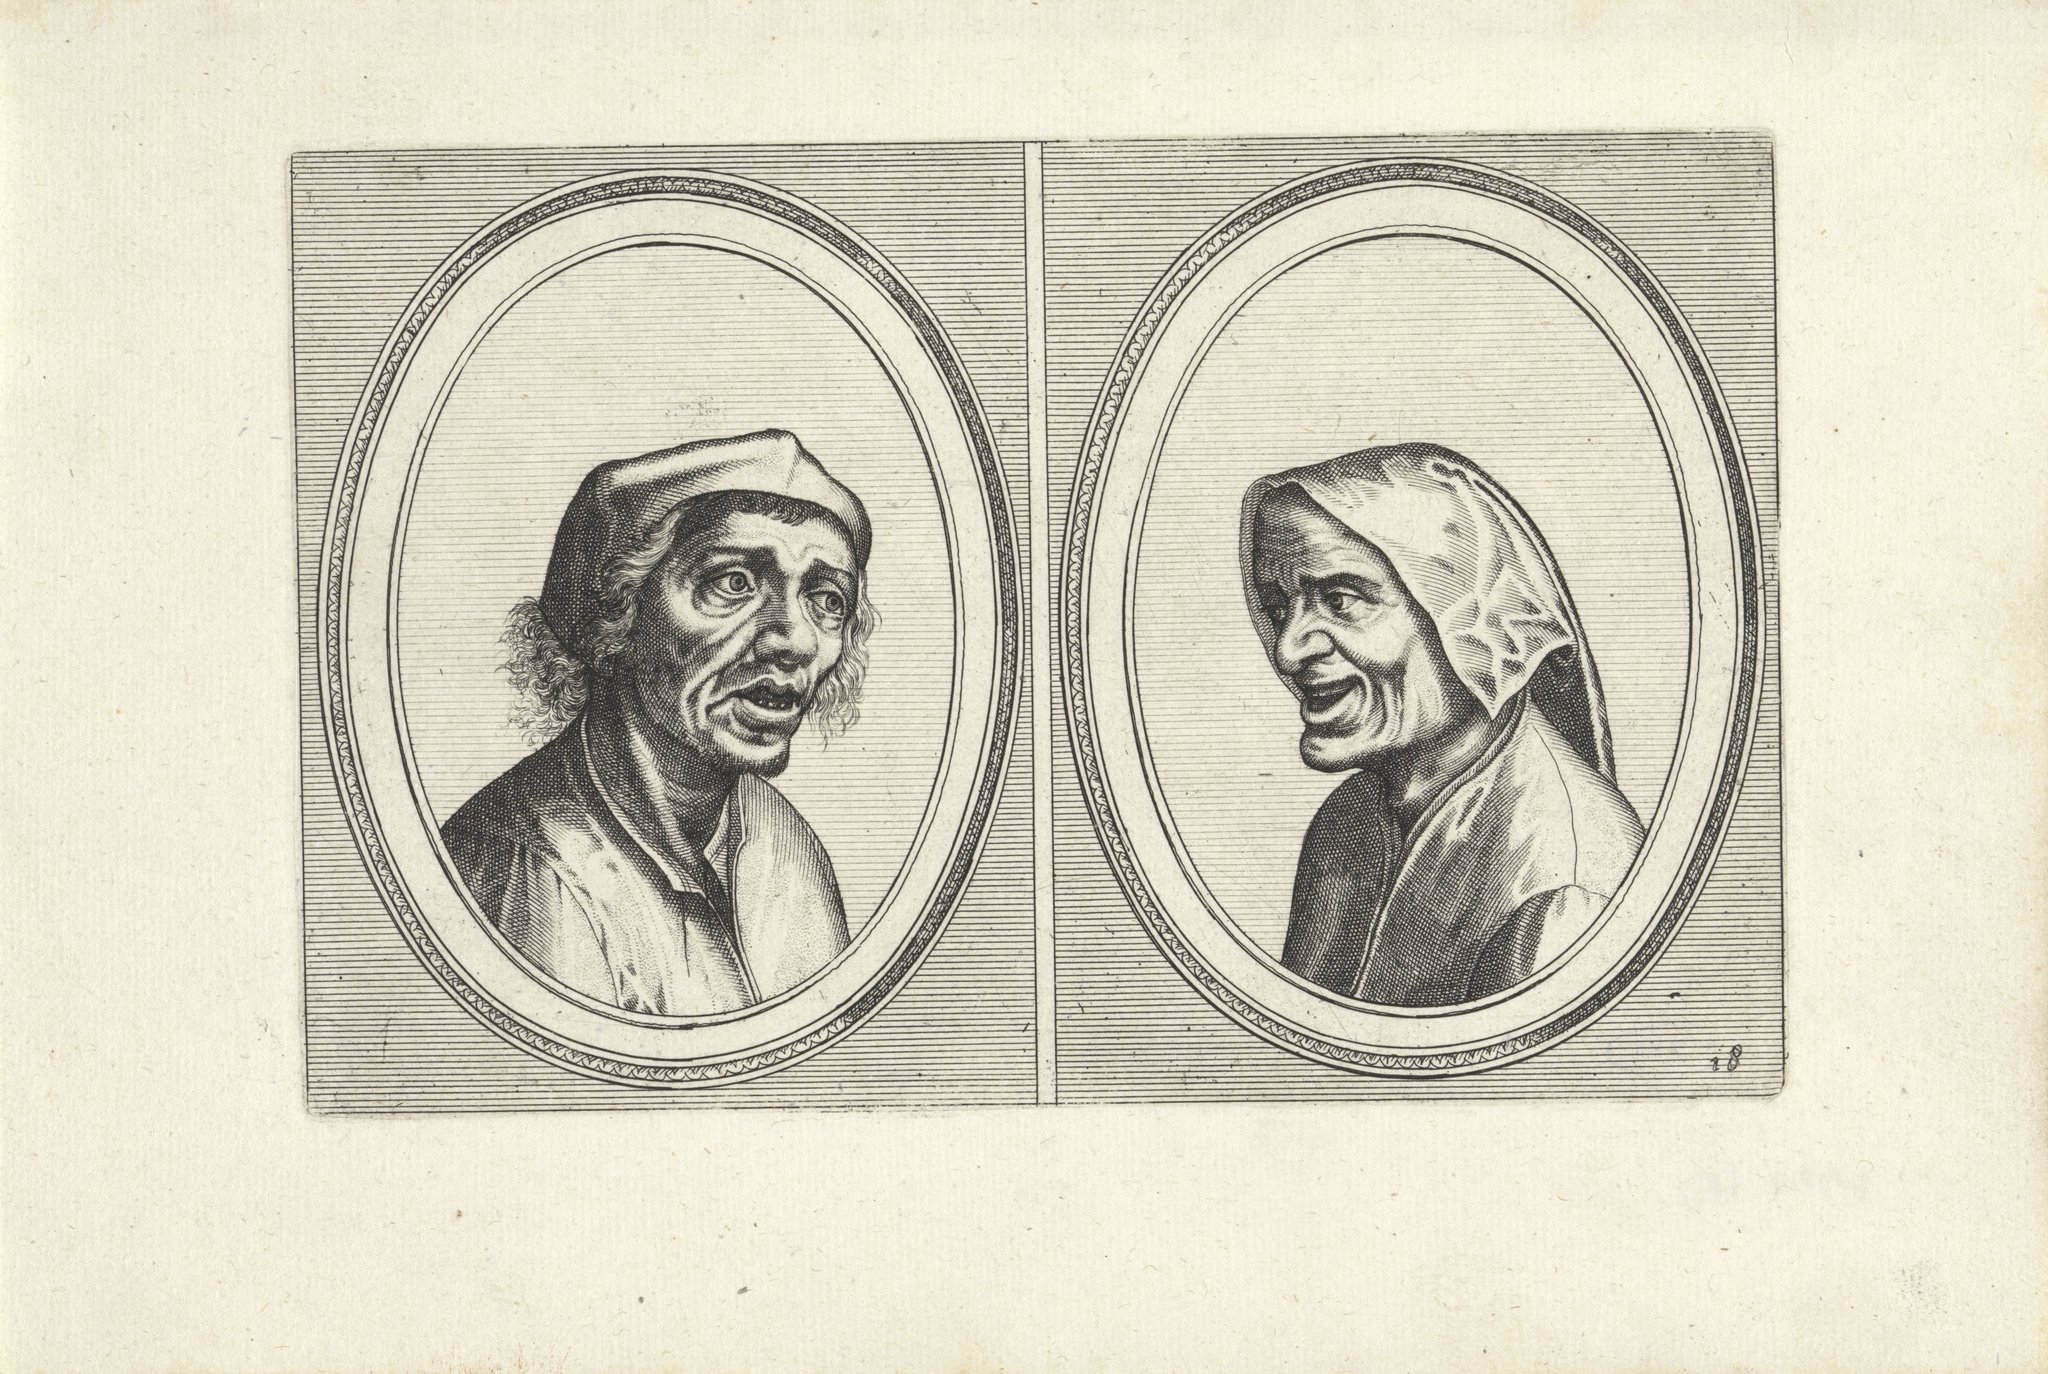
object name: print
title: Goê Geurtjen en Kribbighe Babbe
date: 1612-1652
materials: paper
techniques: engraving, etching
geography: amsterdam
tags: head-gear, farmers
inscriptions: collector's mark: Lugt 2228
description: Prent uit een serie van 36 prenten met koppen van boeren en boerinnen.